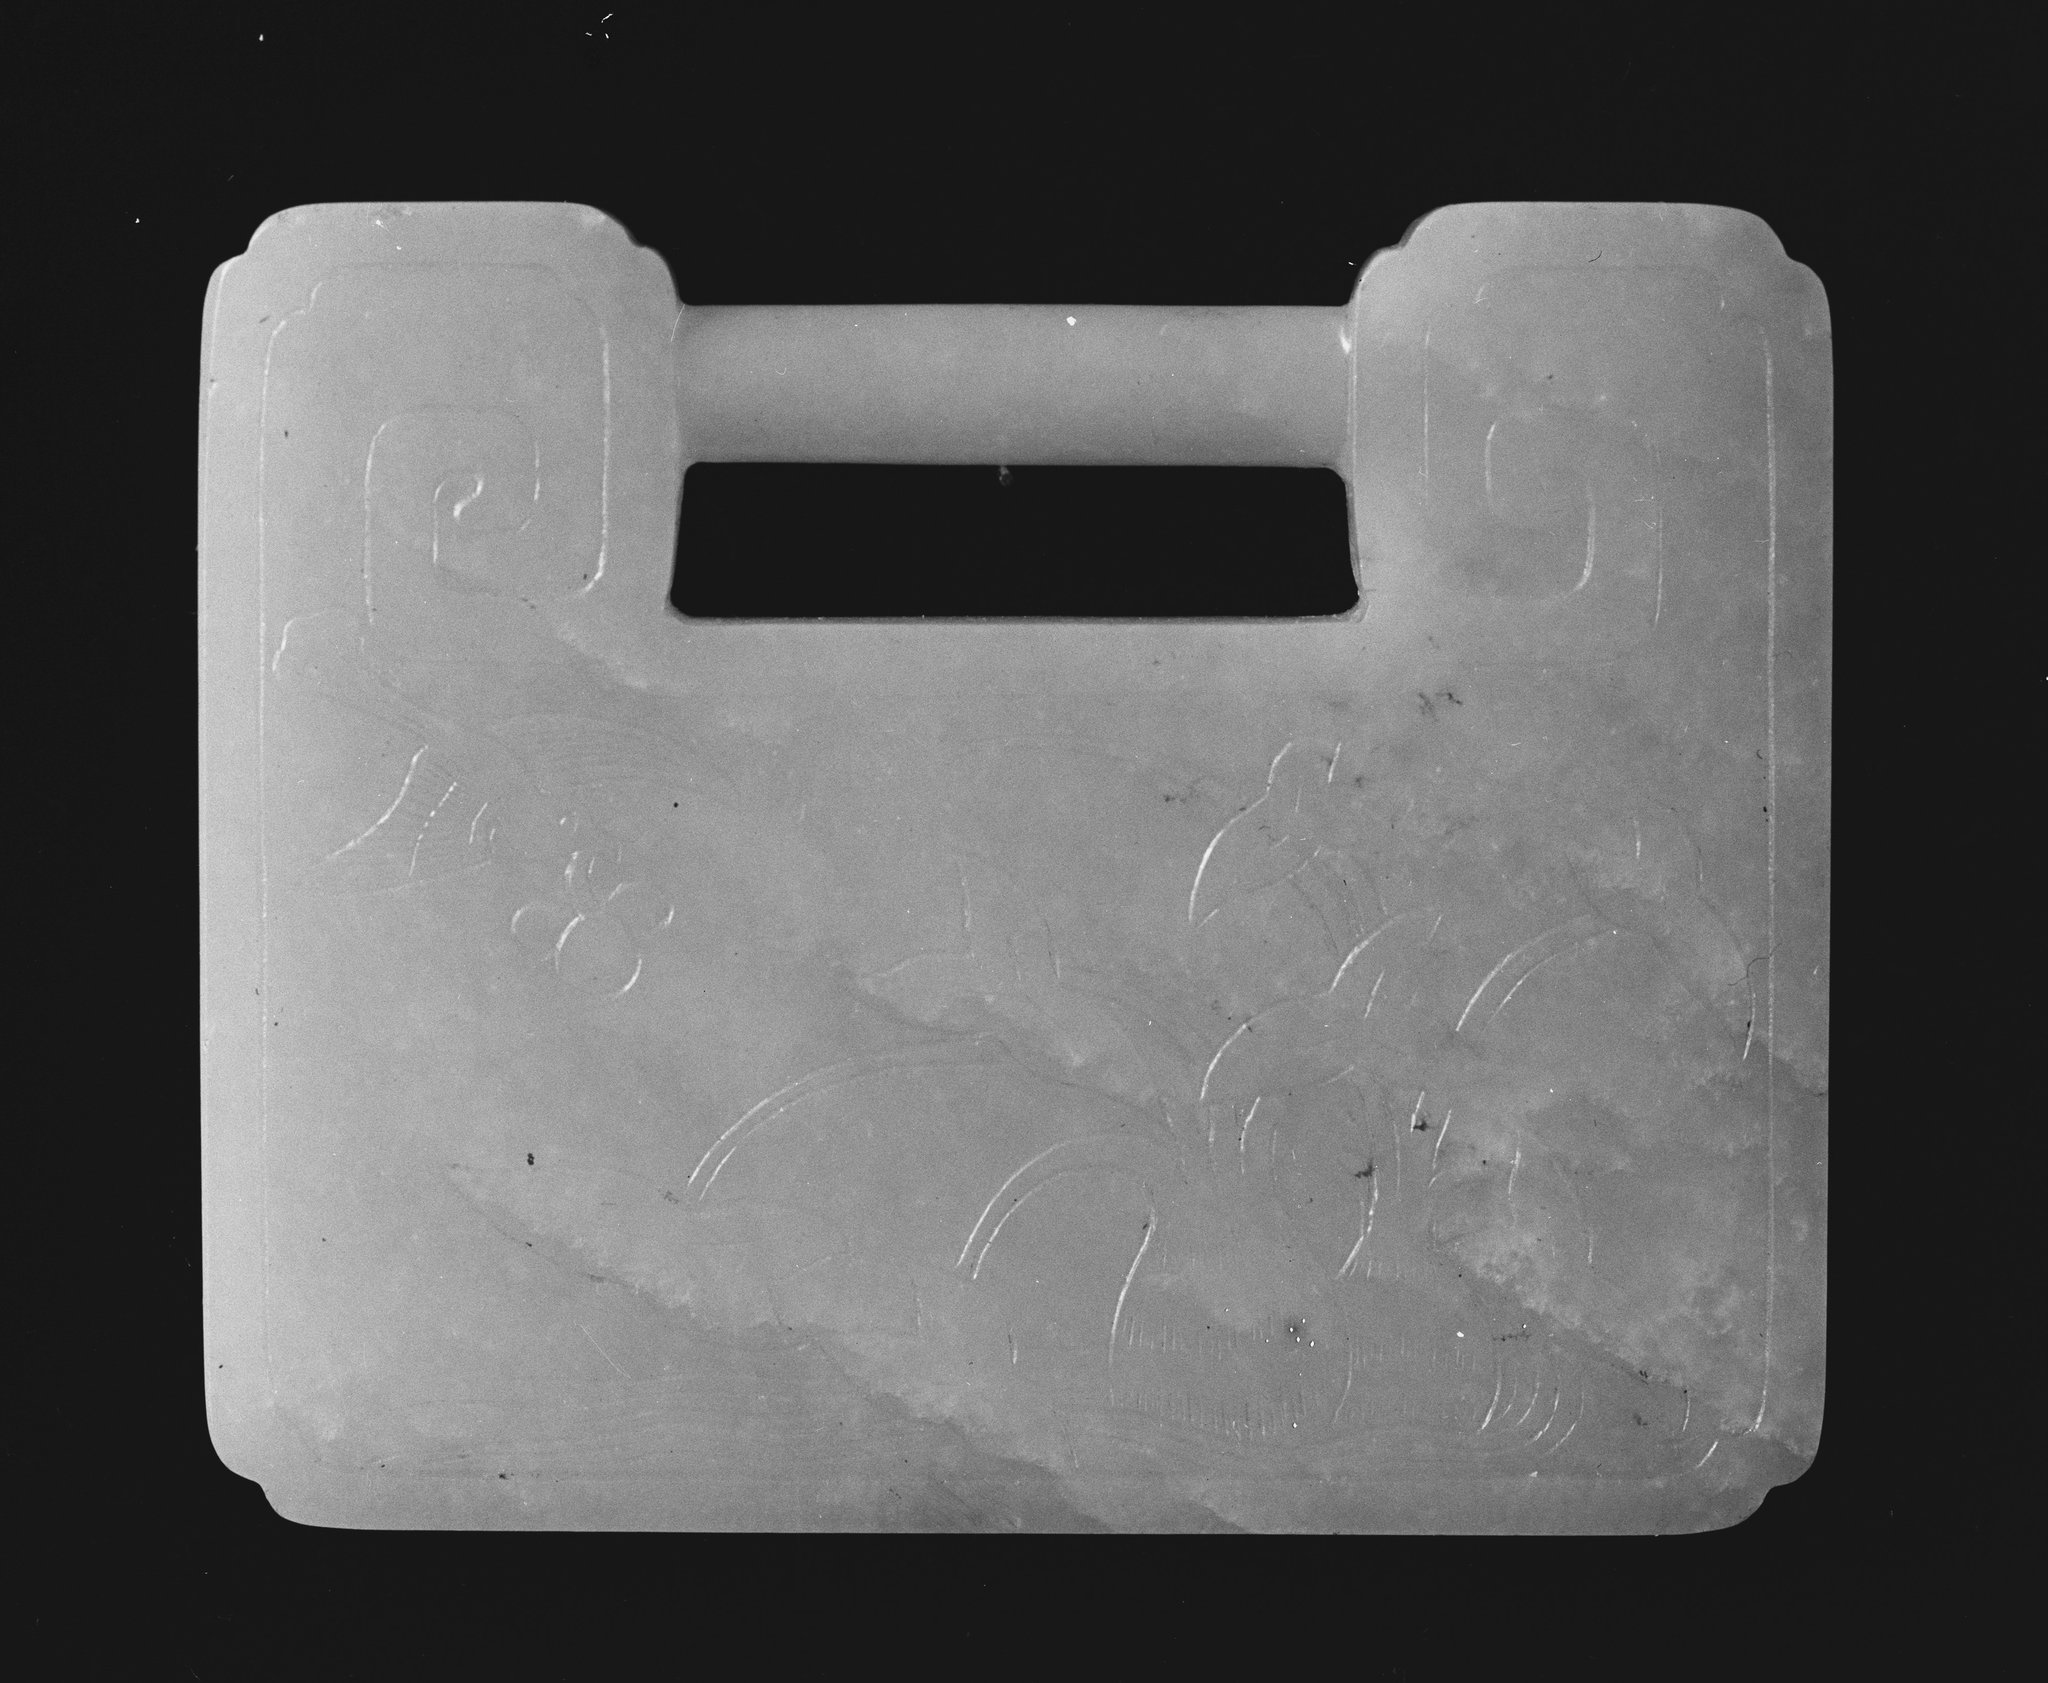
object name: pendant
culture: chinese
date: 1723-1735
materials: jade